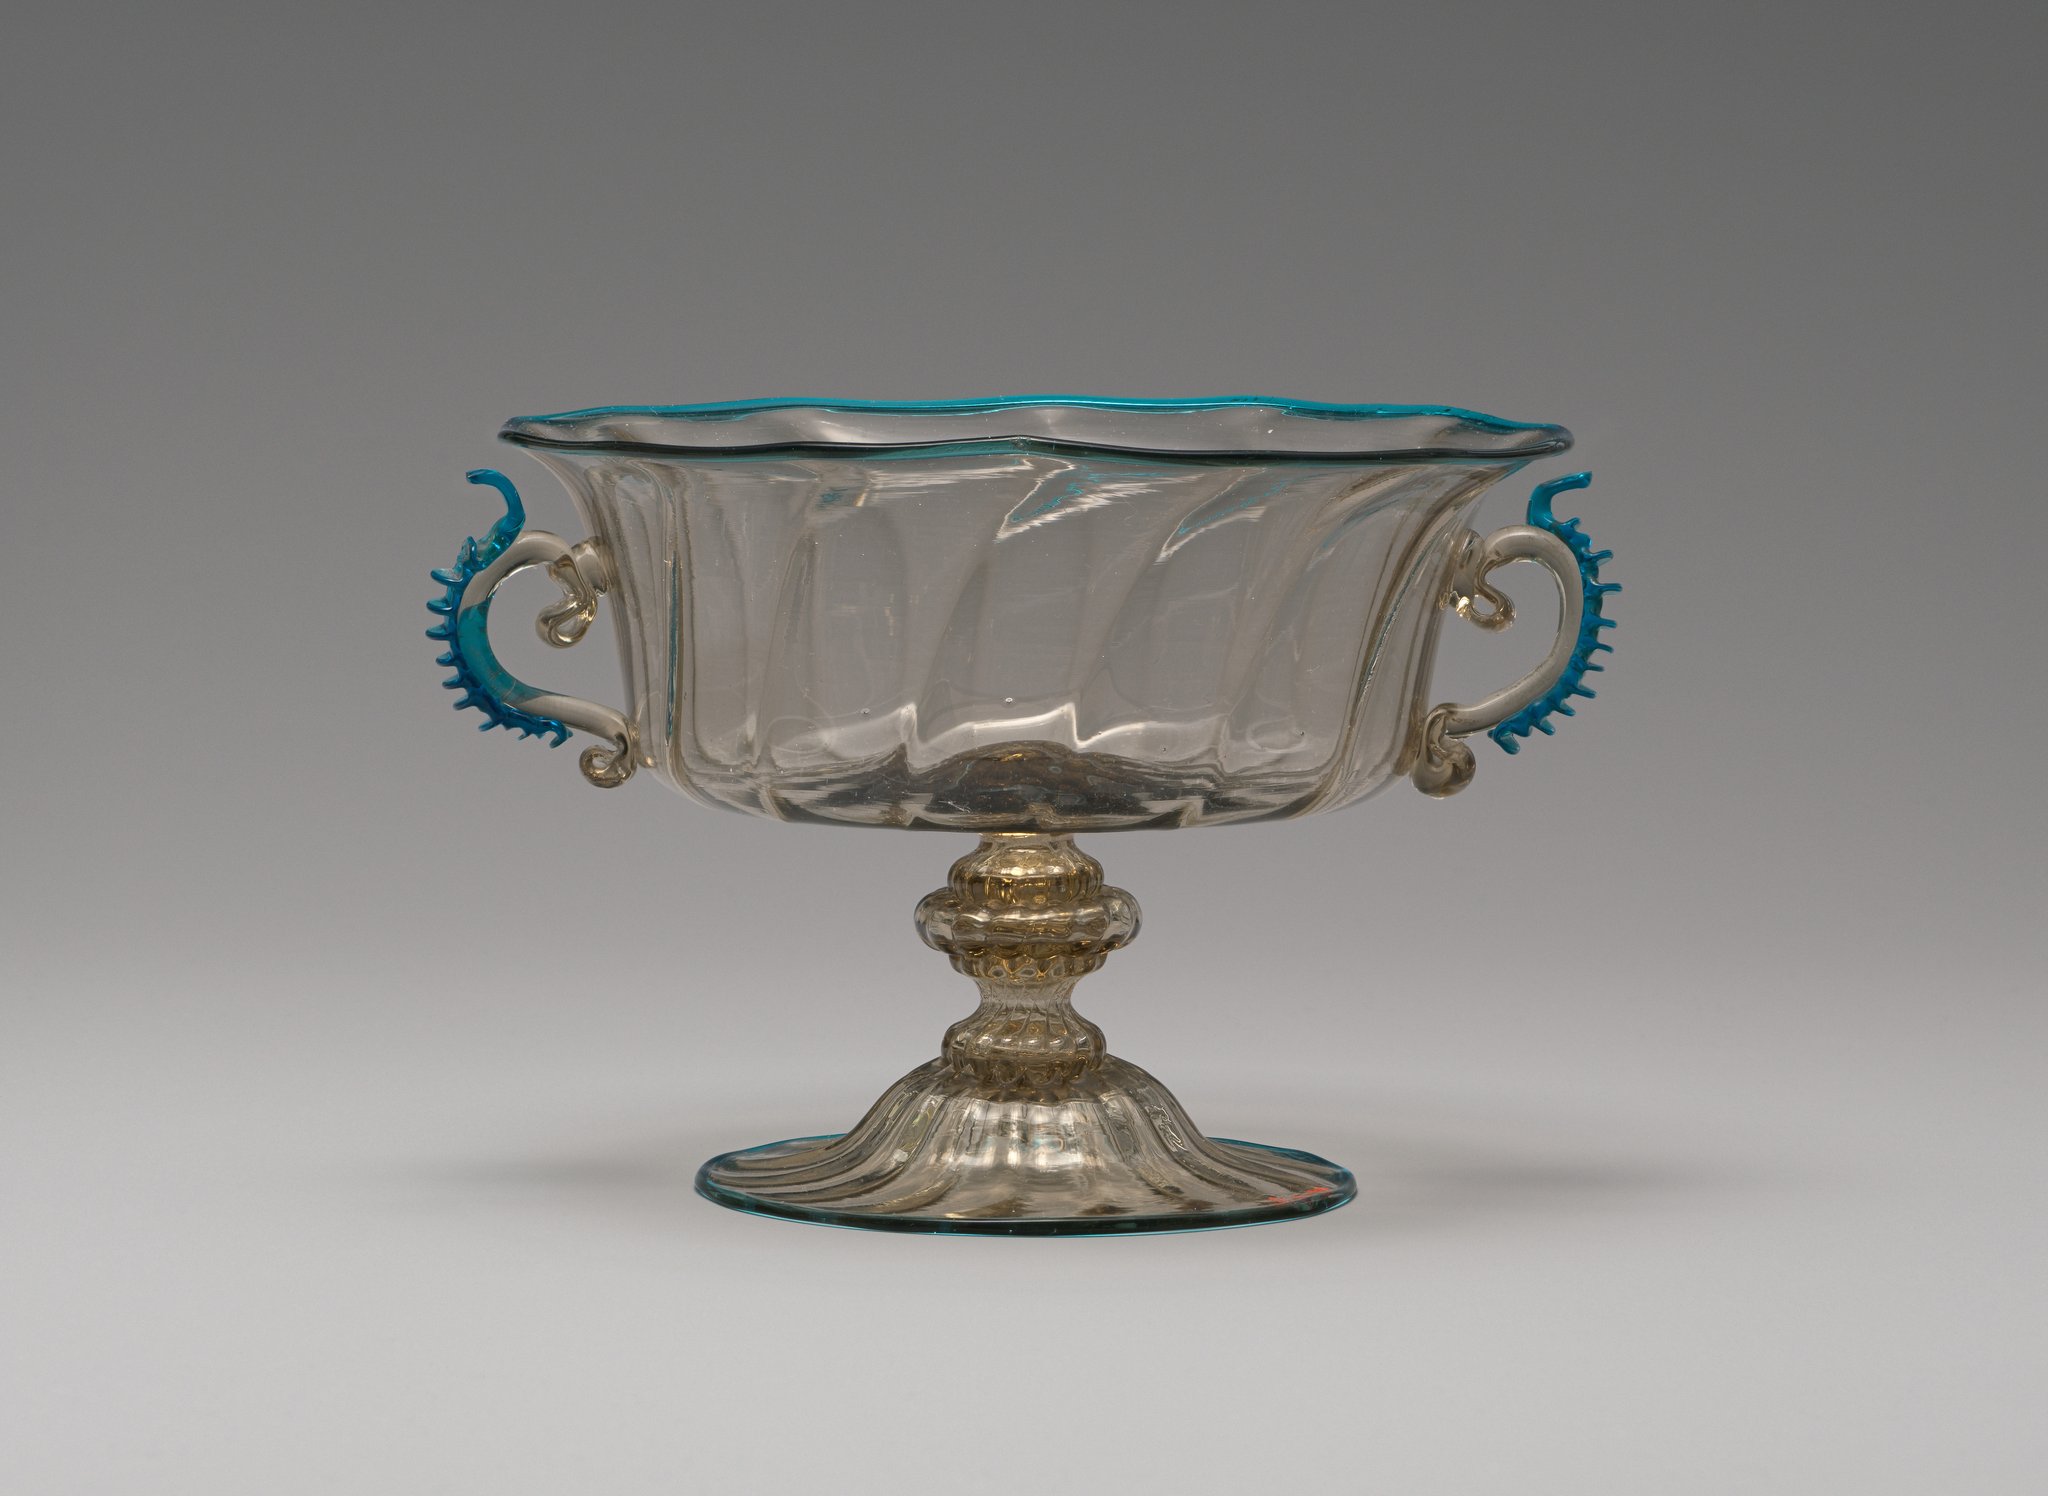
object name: bowl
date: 1601-1700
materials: glass